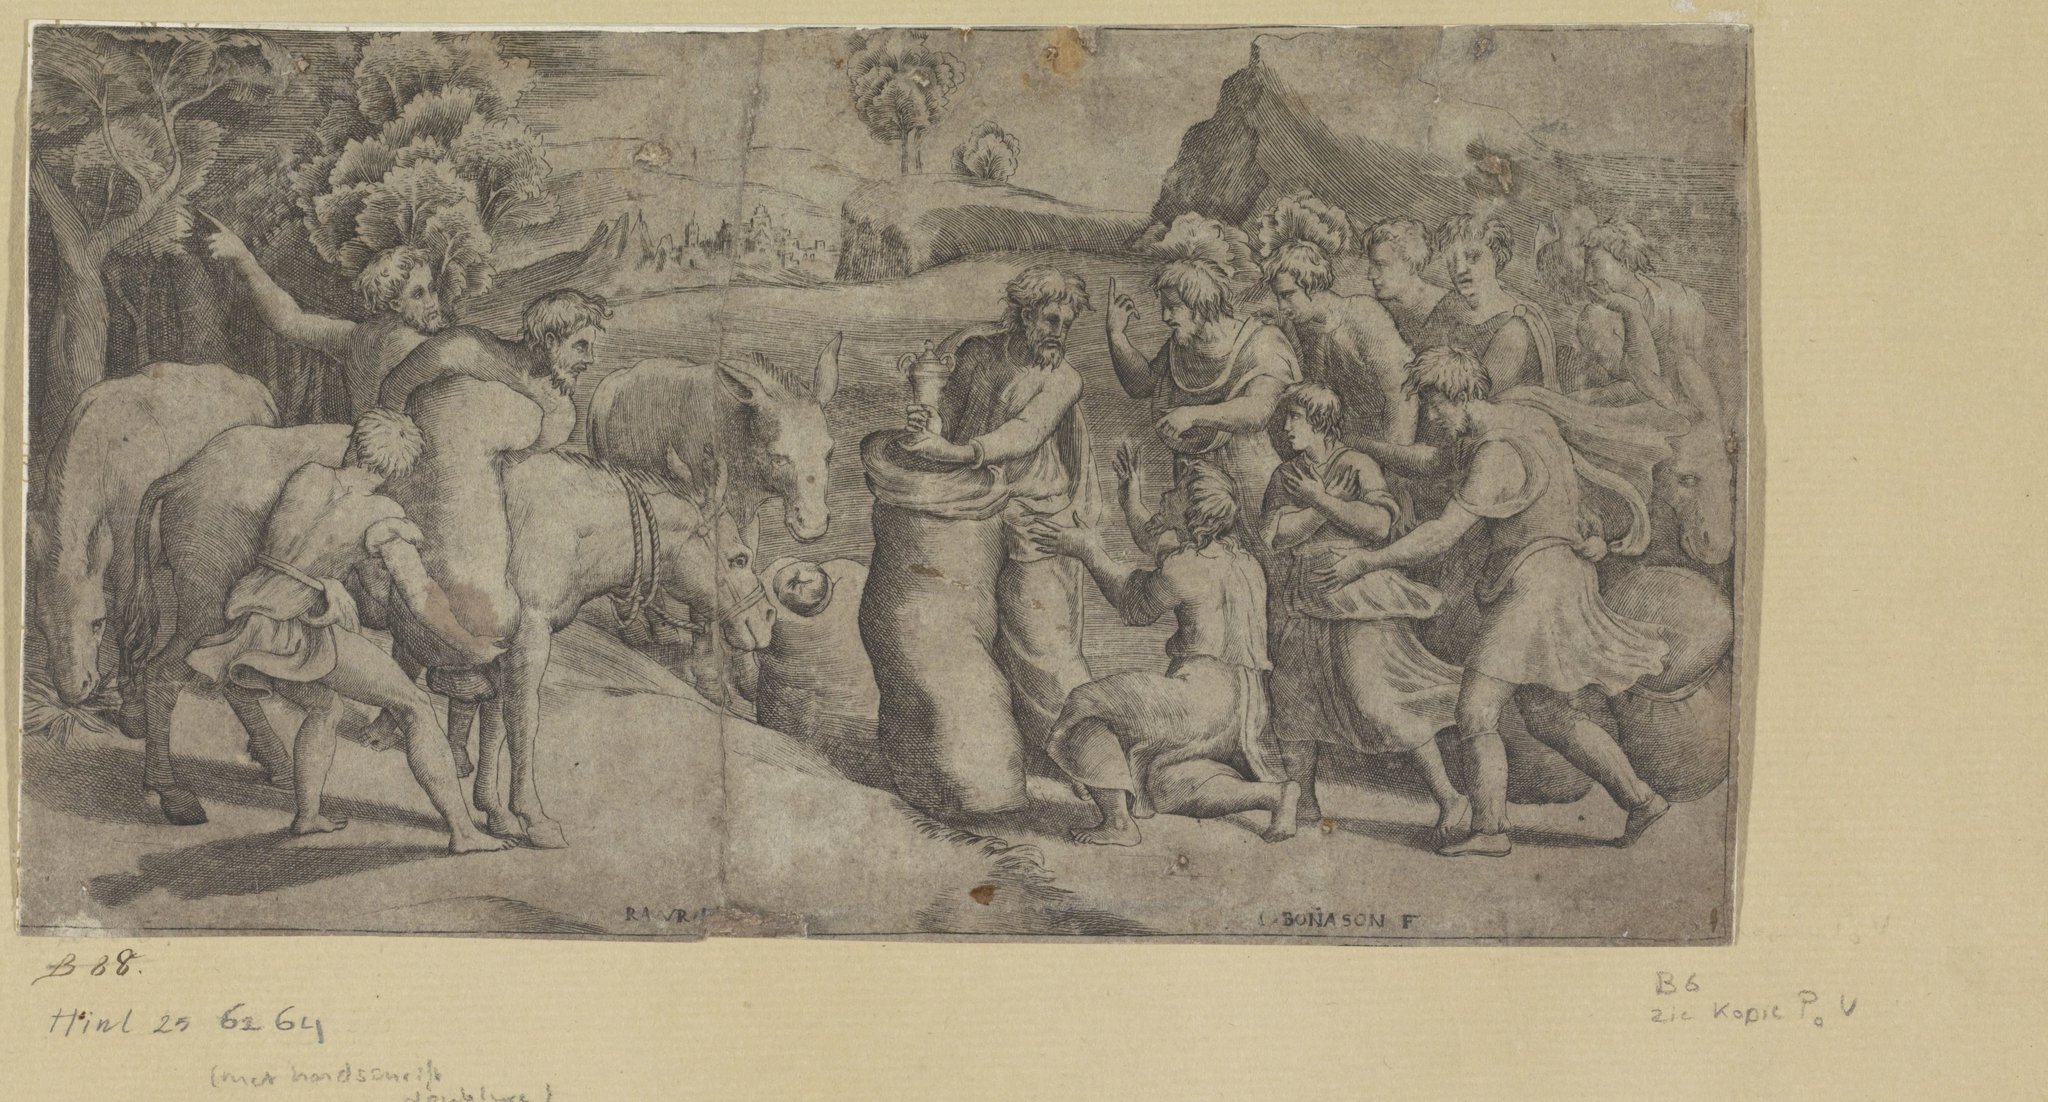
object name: print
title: Beker van Jozef ontdekt in Benjamins graanzak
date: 1501-1580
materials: paper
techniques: engraving, etching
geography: italy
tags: the cup is found in benjamin's sack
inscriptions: collector's mark: ‘Hinloopen’, collector's mark: Lugt 10, collector's mark: Lugt 11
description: De beker van Jozef wordt ontdekt in de graanzak van Benjamin. Links staan drie muilezels, waarvan er een bepakt wordt met graan. Rechts de broers van Jozef.